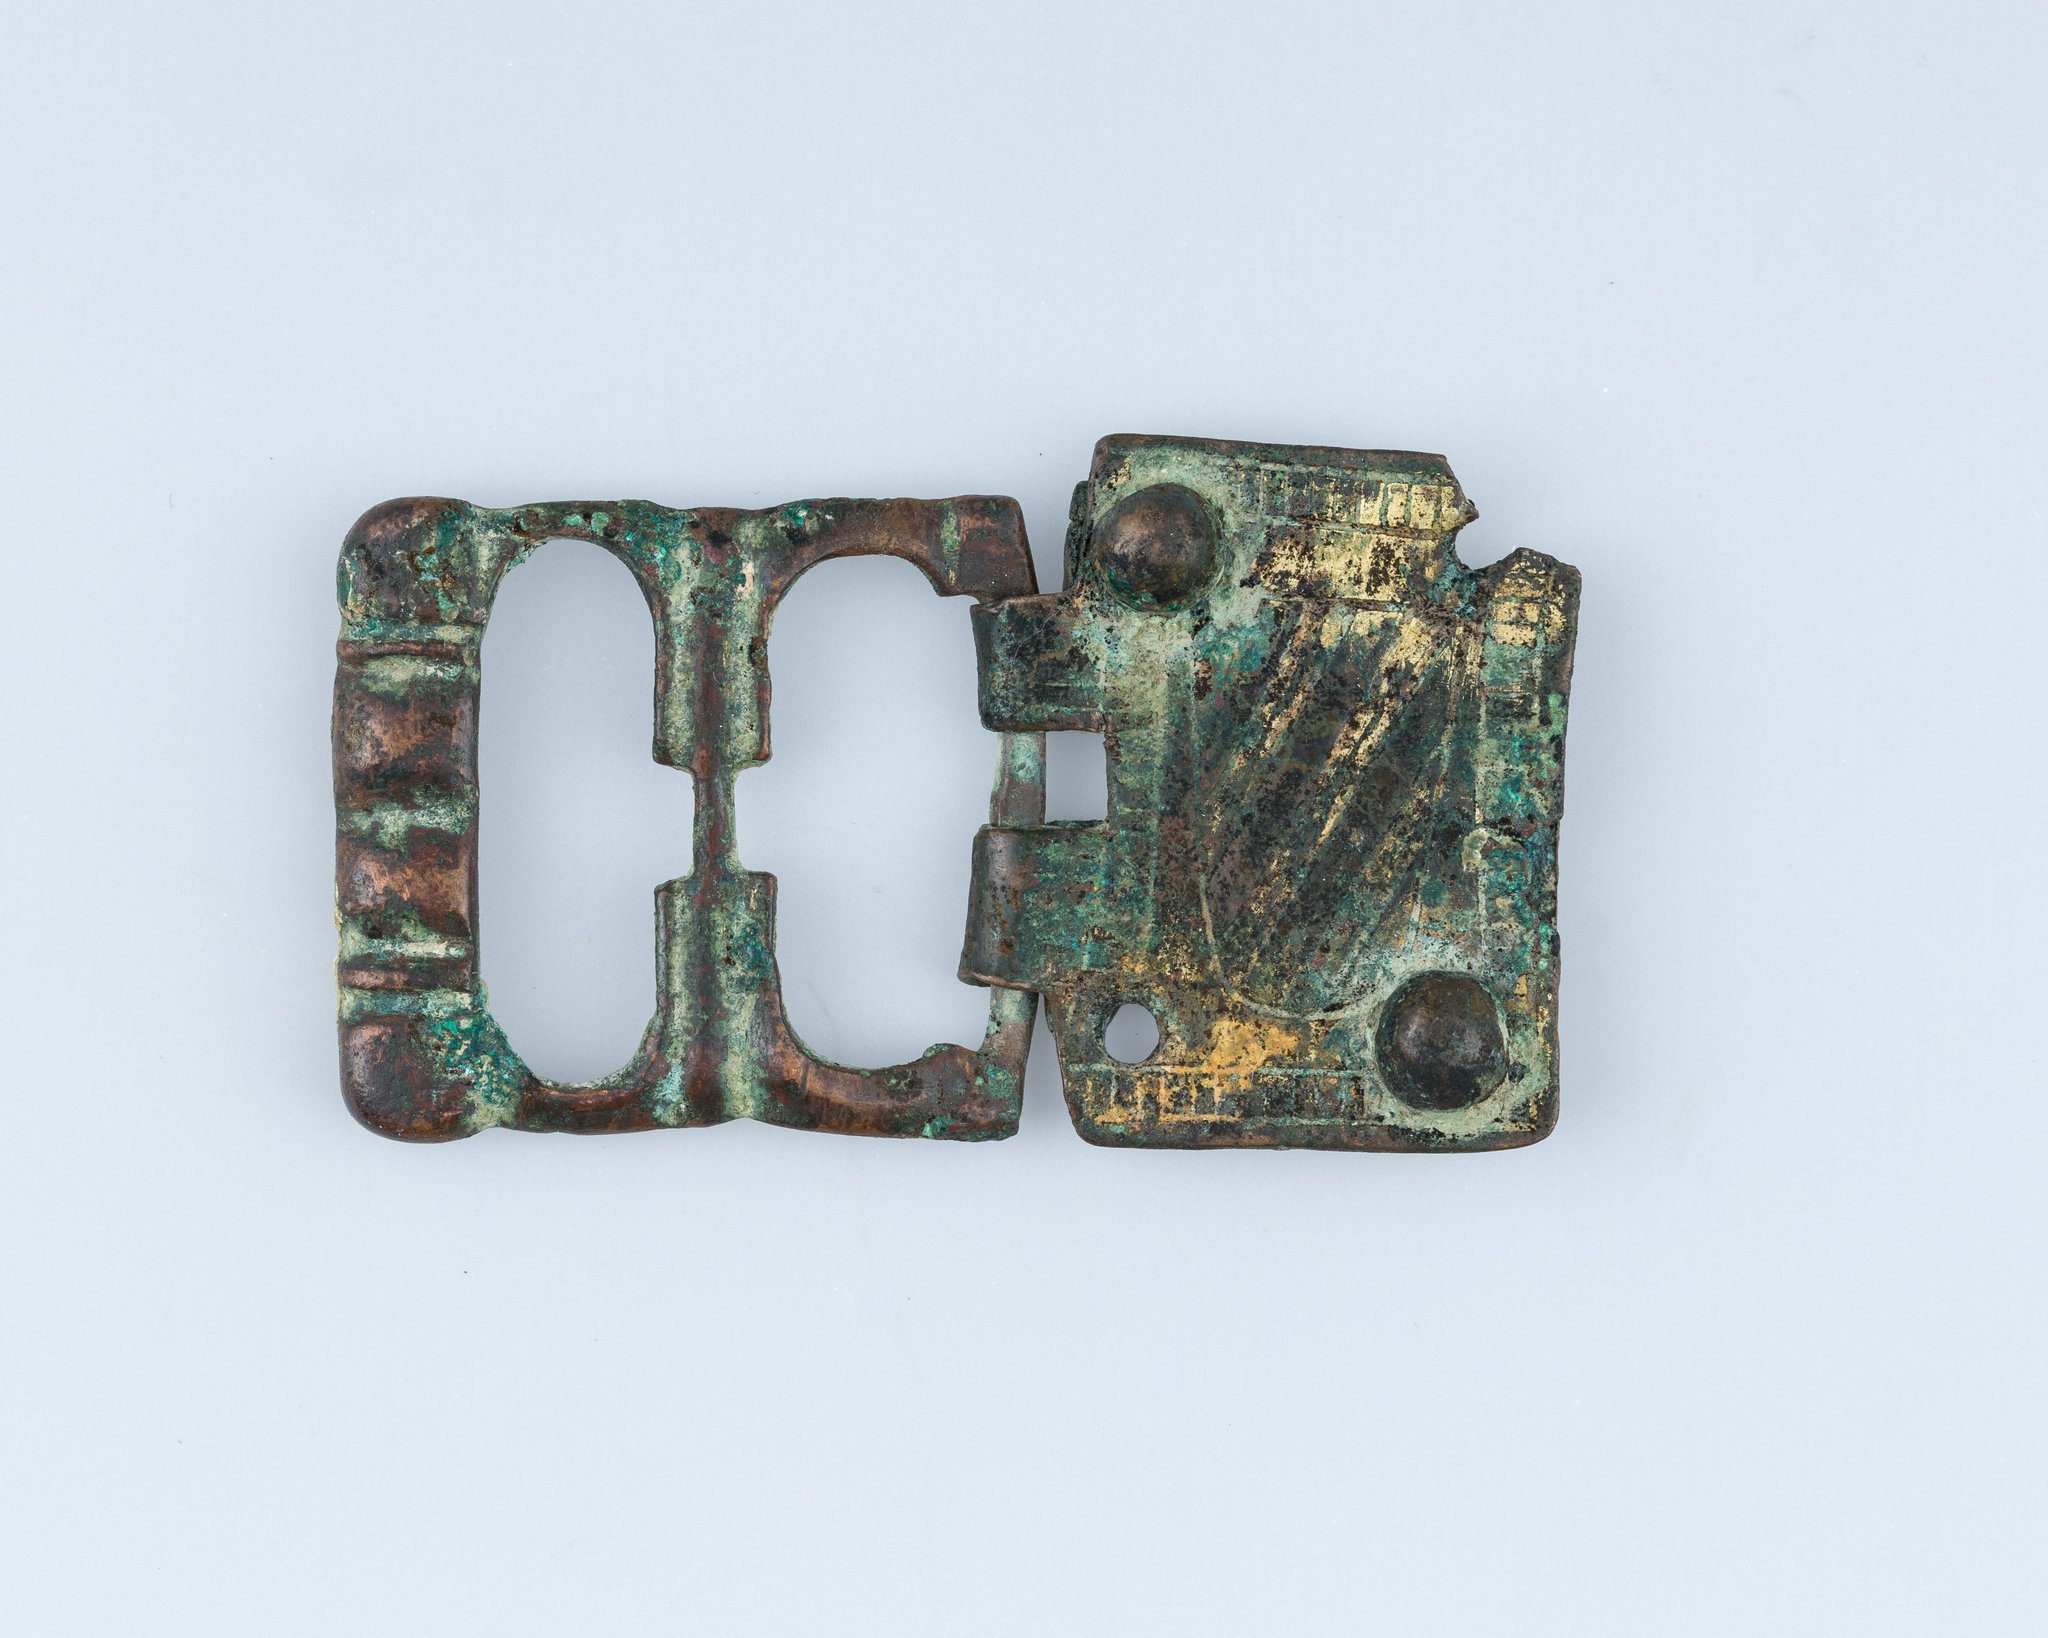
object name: buckle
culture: french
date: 1301-1400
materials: bronze, gilt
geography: france